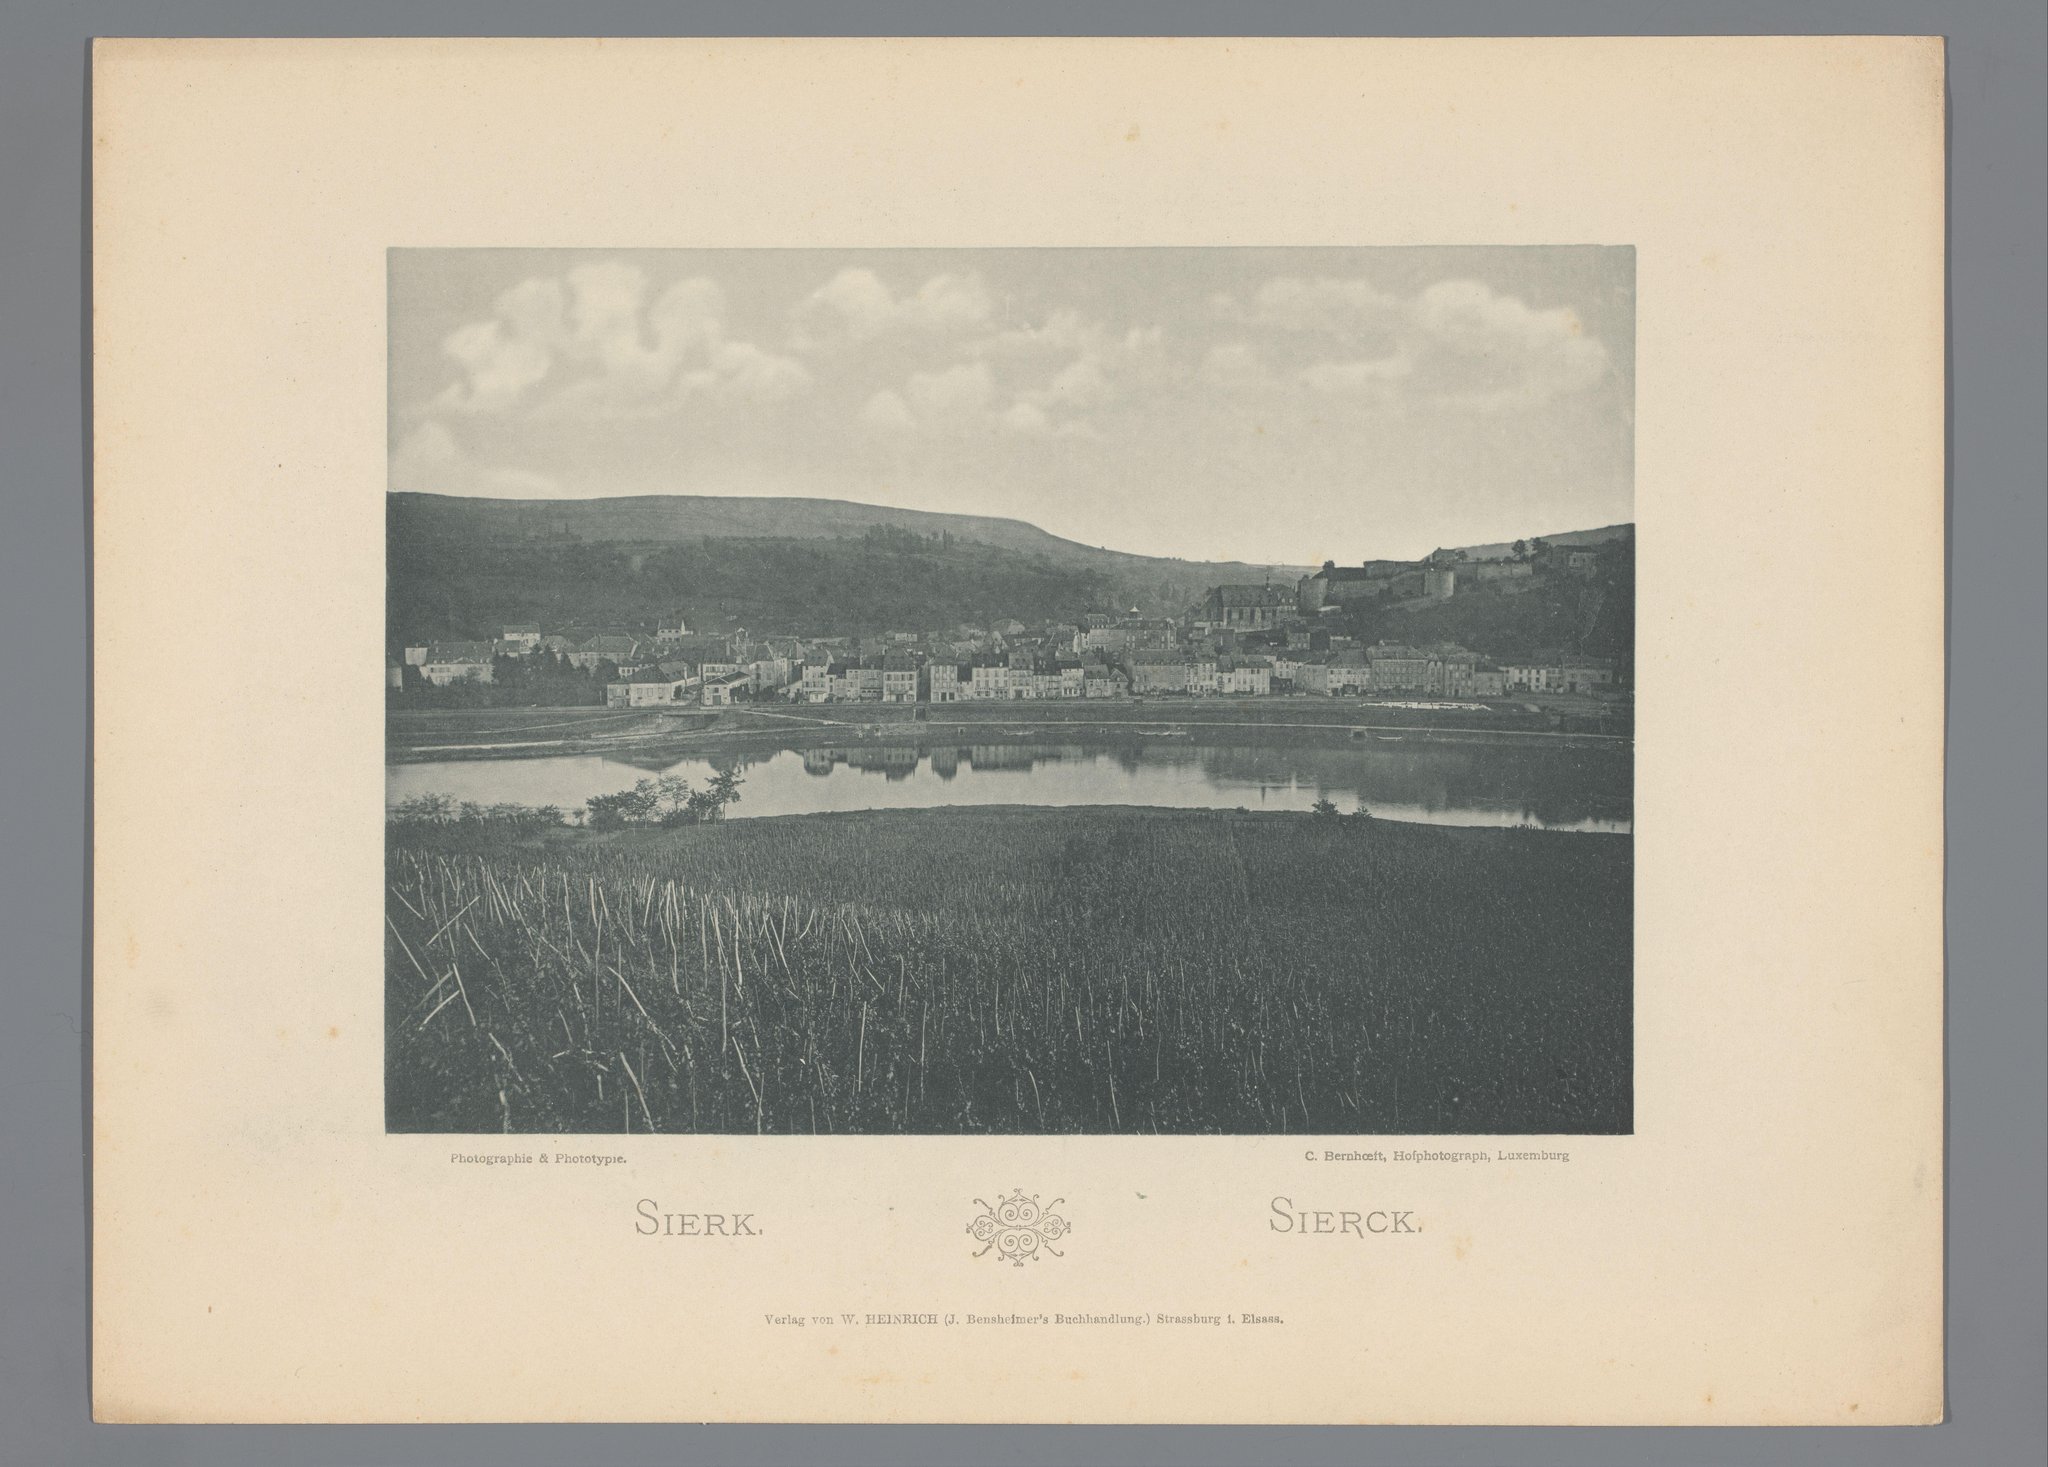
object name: photomechanical print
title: Sierk, Sierck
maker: charles bernhoeft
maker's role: publisher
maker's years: 1859-1933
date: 1889-1894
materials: paper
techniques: photograph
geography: straatsburg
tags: city-view in general; 'veduta', river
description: Deze prent maakt deel uit van een omslag met 100 prenten.